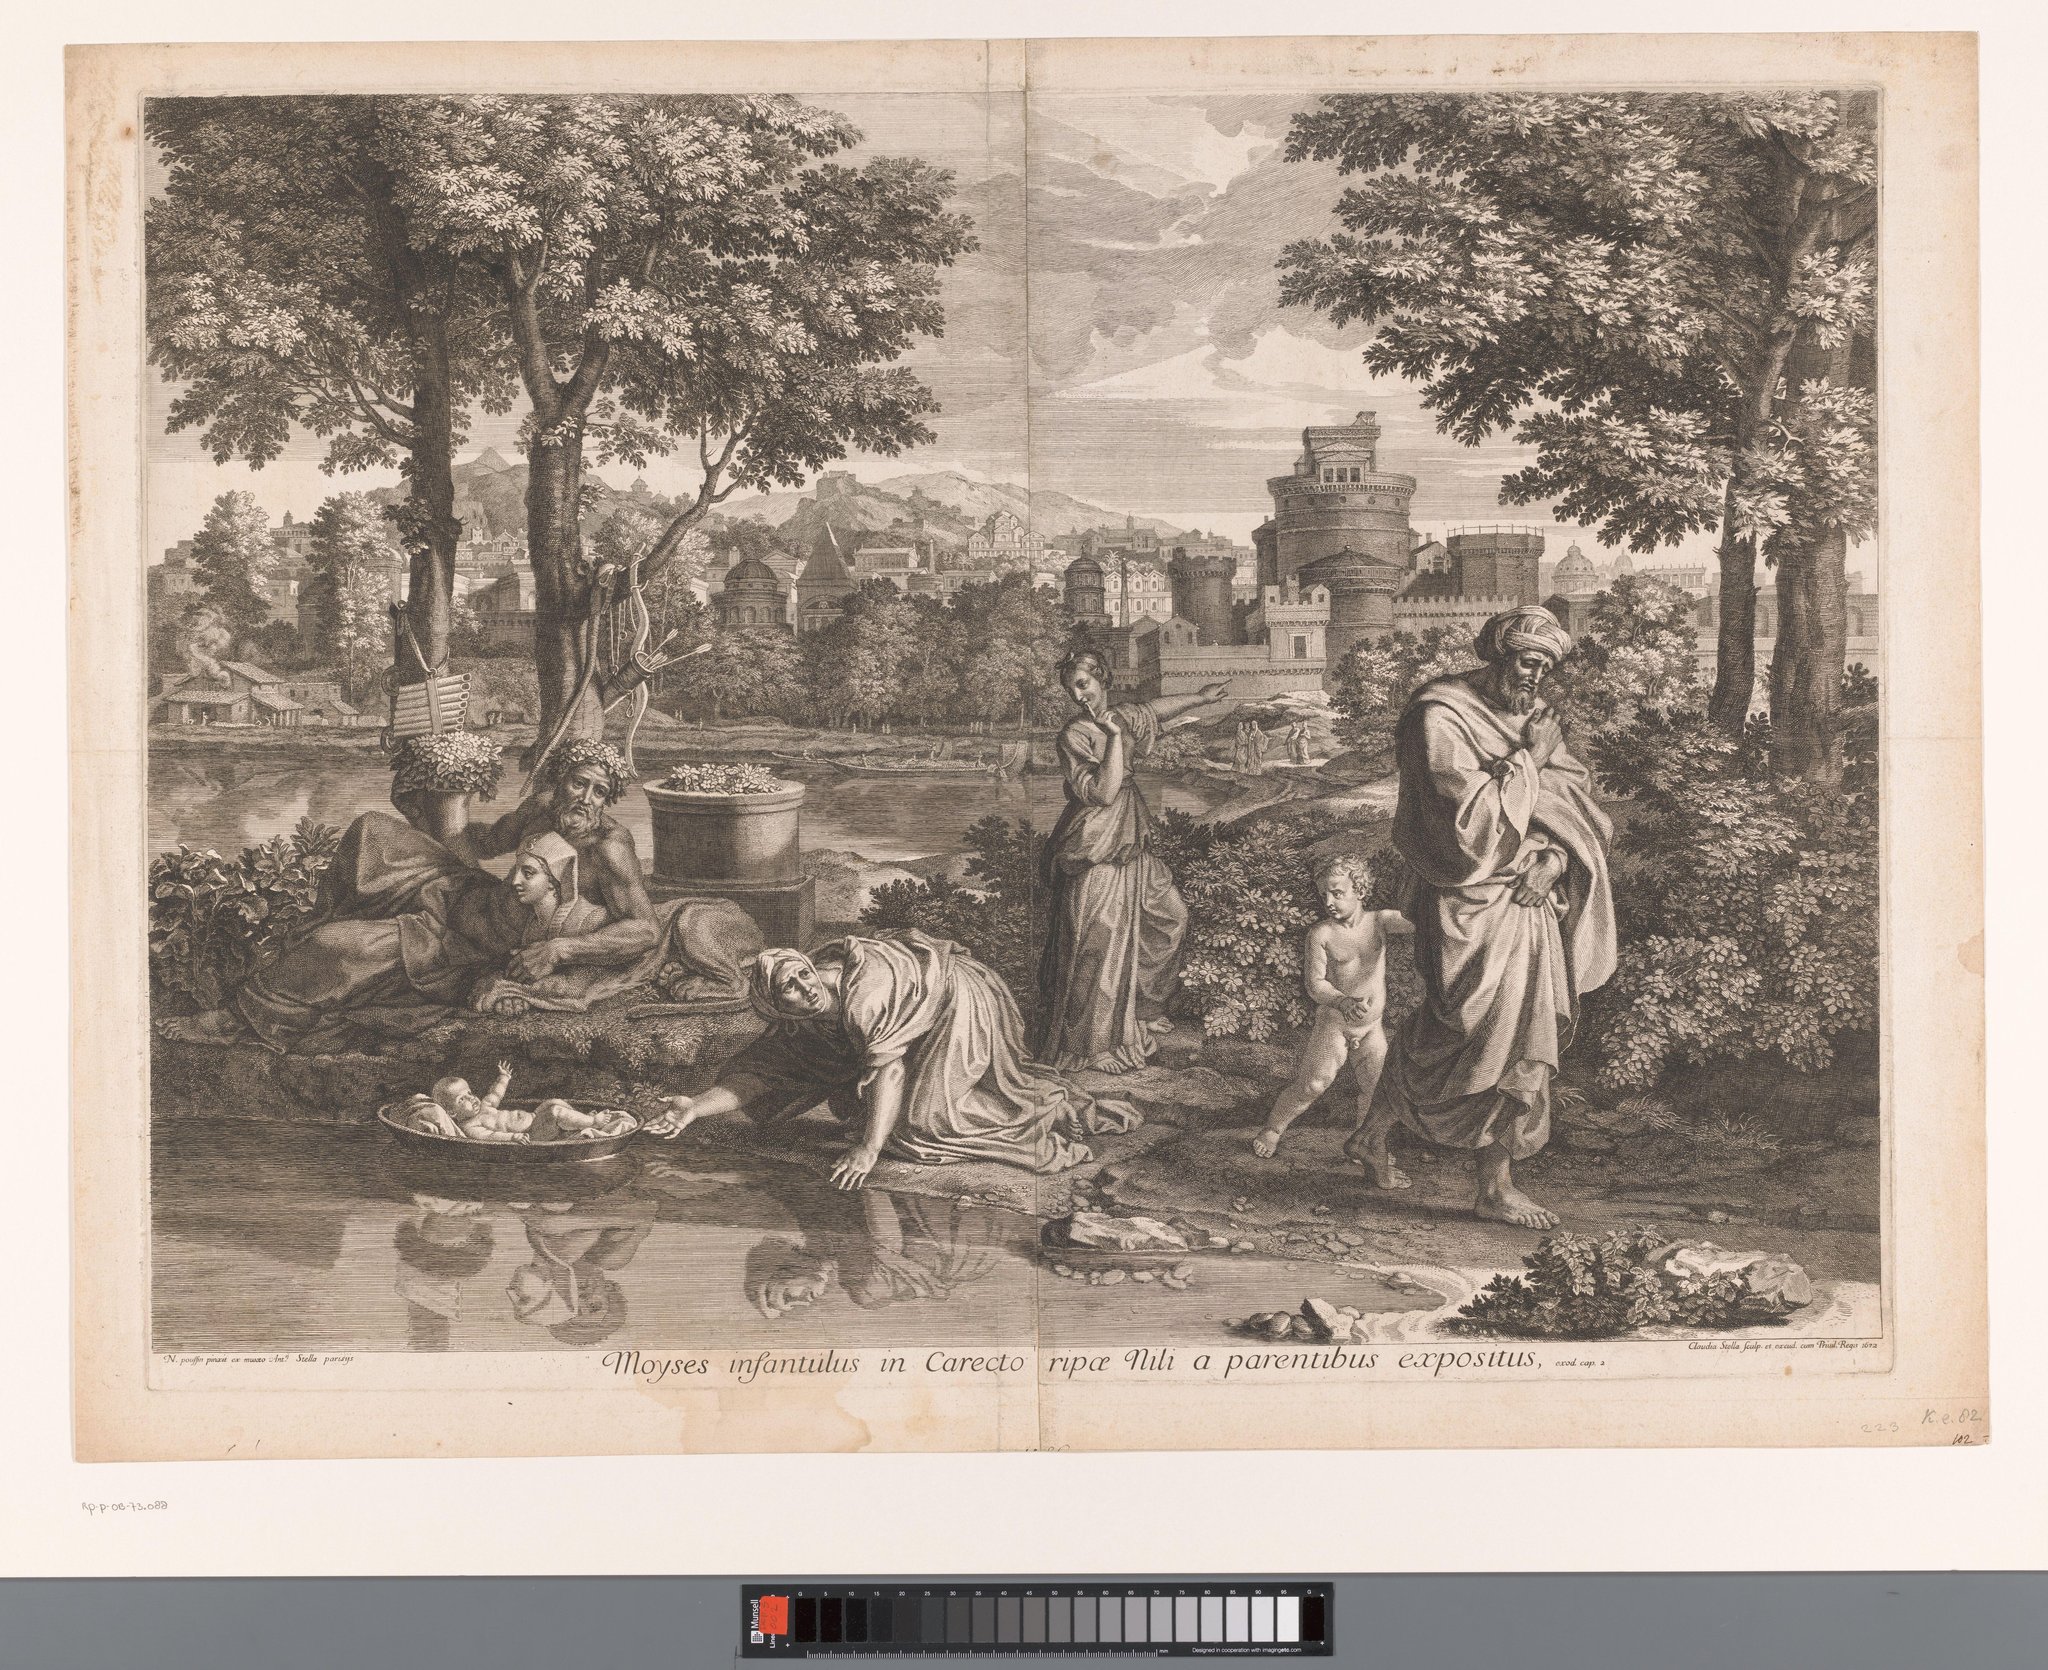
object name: print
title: Moyses infantulus in carecto ripae Nili a parentibus expositus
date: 1672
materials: paper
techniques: engraving, etching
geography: france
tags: 71e1123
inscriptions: collector's mark: Lugt 2233